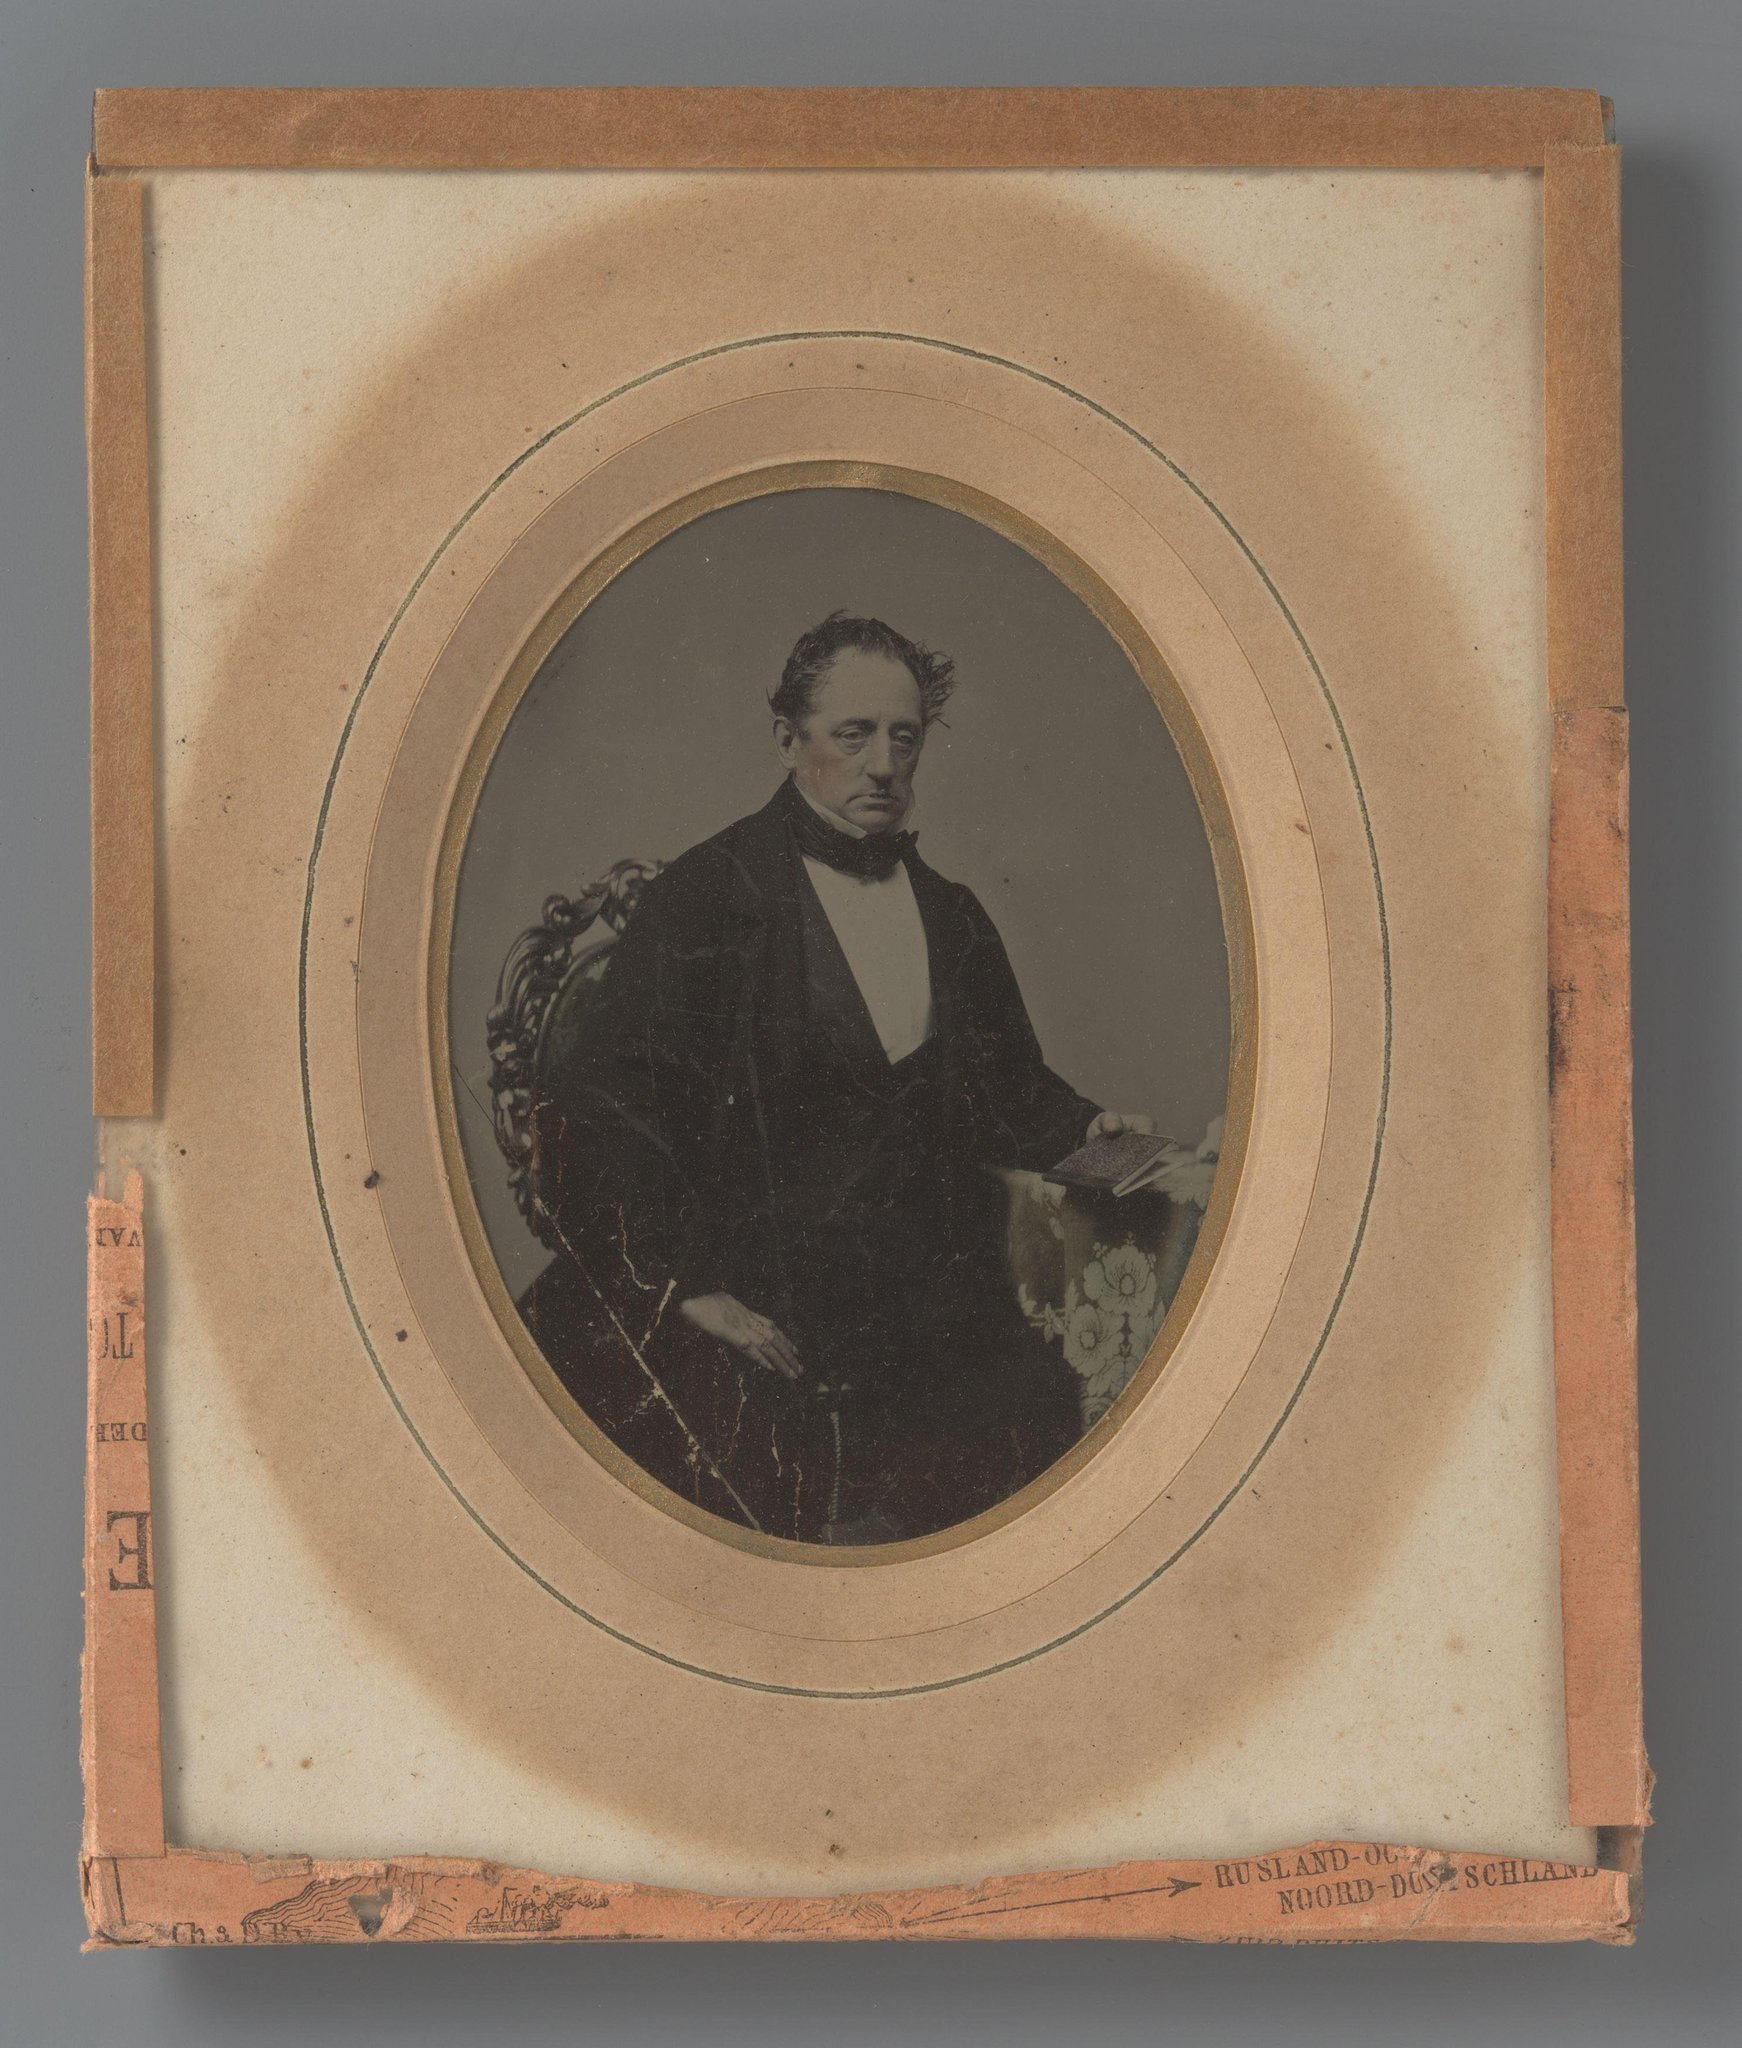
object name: photograph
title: Portret van een zittende man met boek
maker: peter carstensen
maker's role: fotograaf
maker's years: 1817-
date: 1860-1868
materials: cardboard, glass, paper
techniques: ambrotype, hand coloring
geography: amsterdam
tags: sitting figure, historical persons